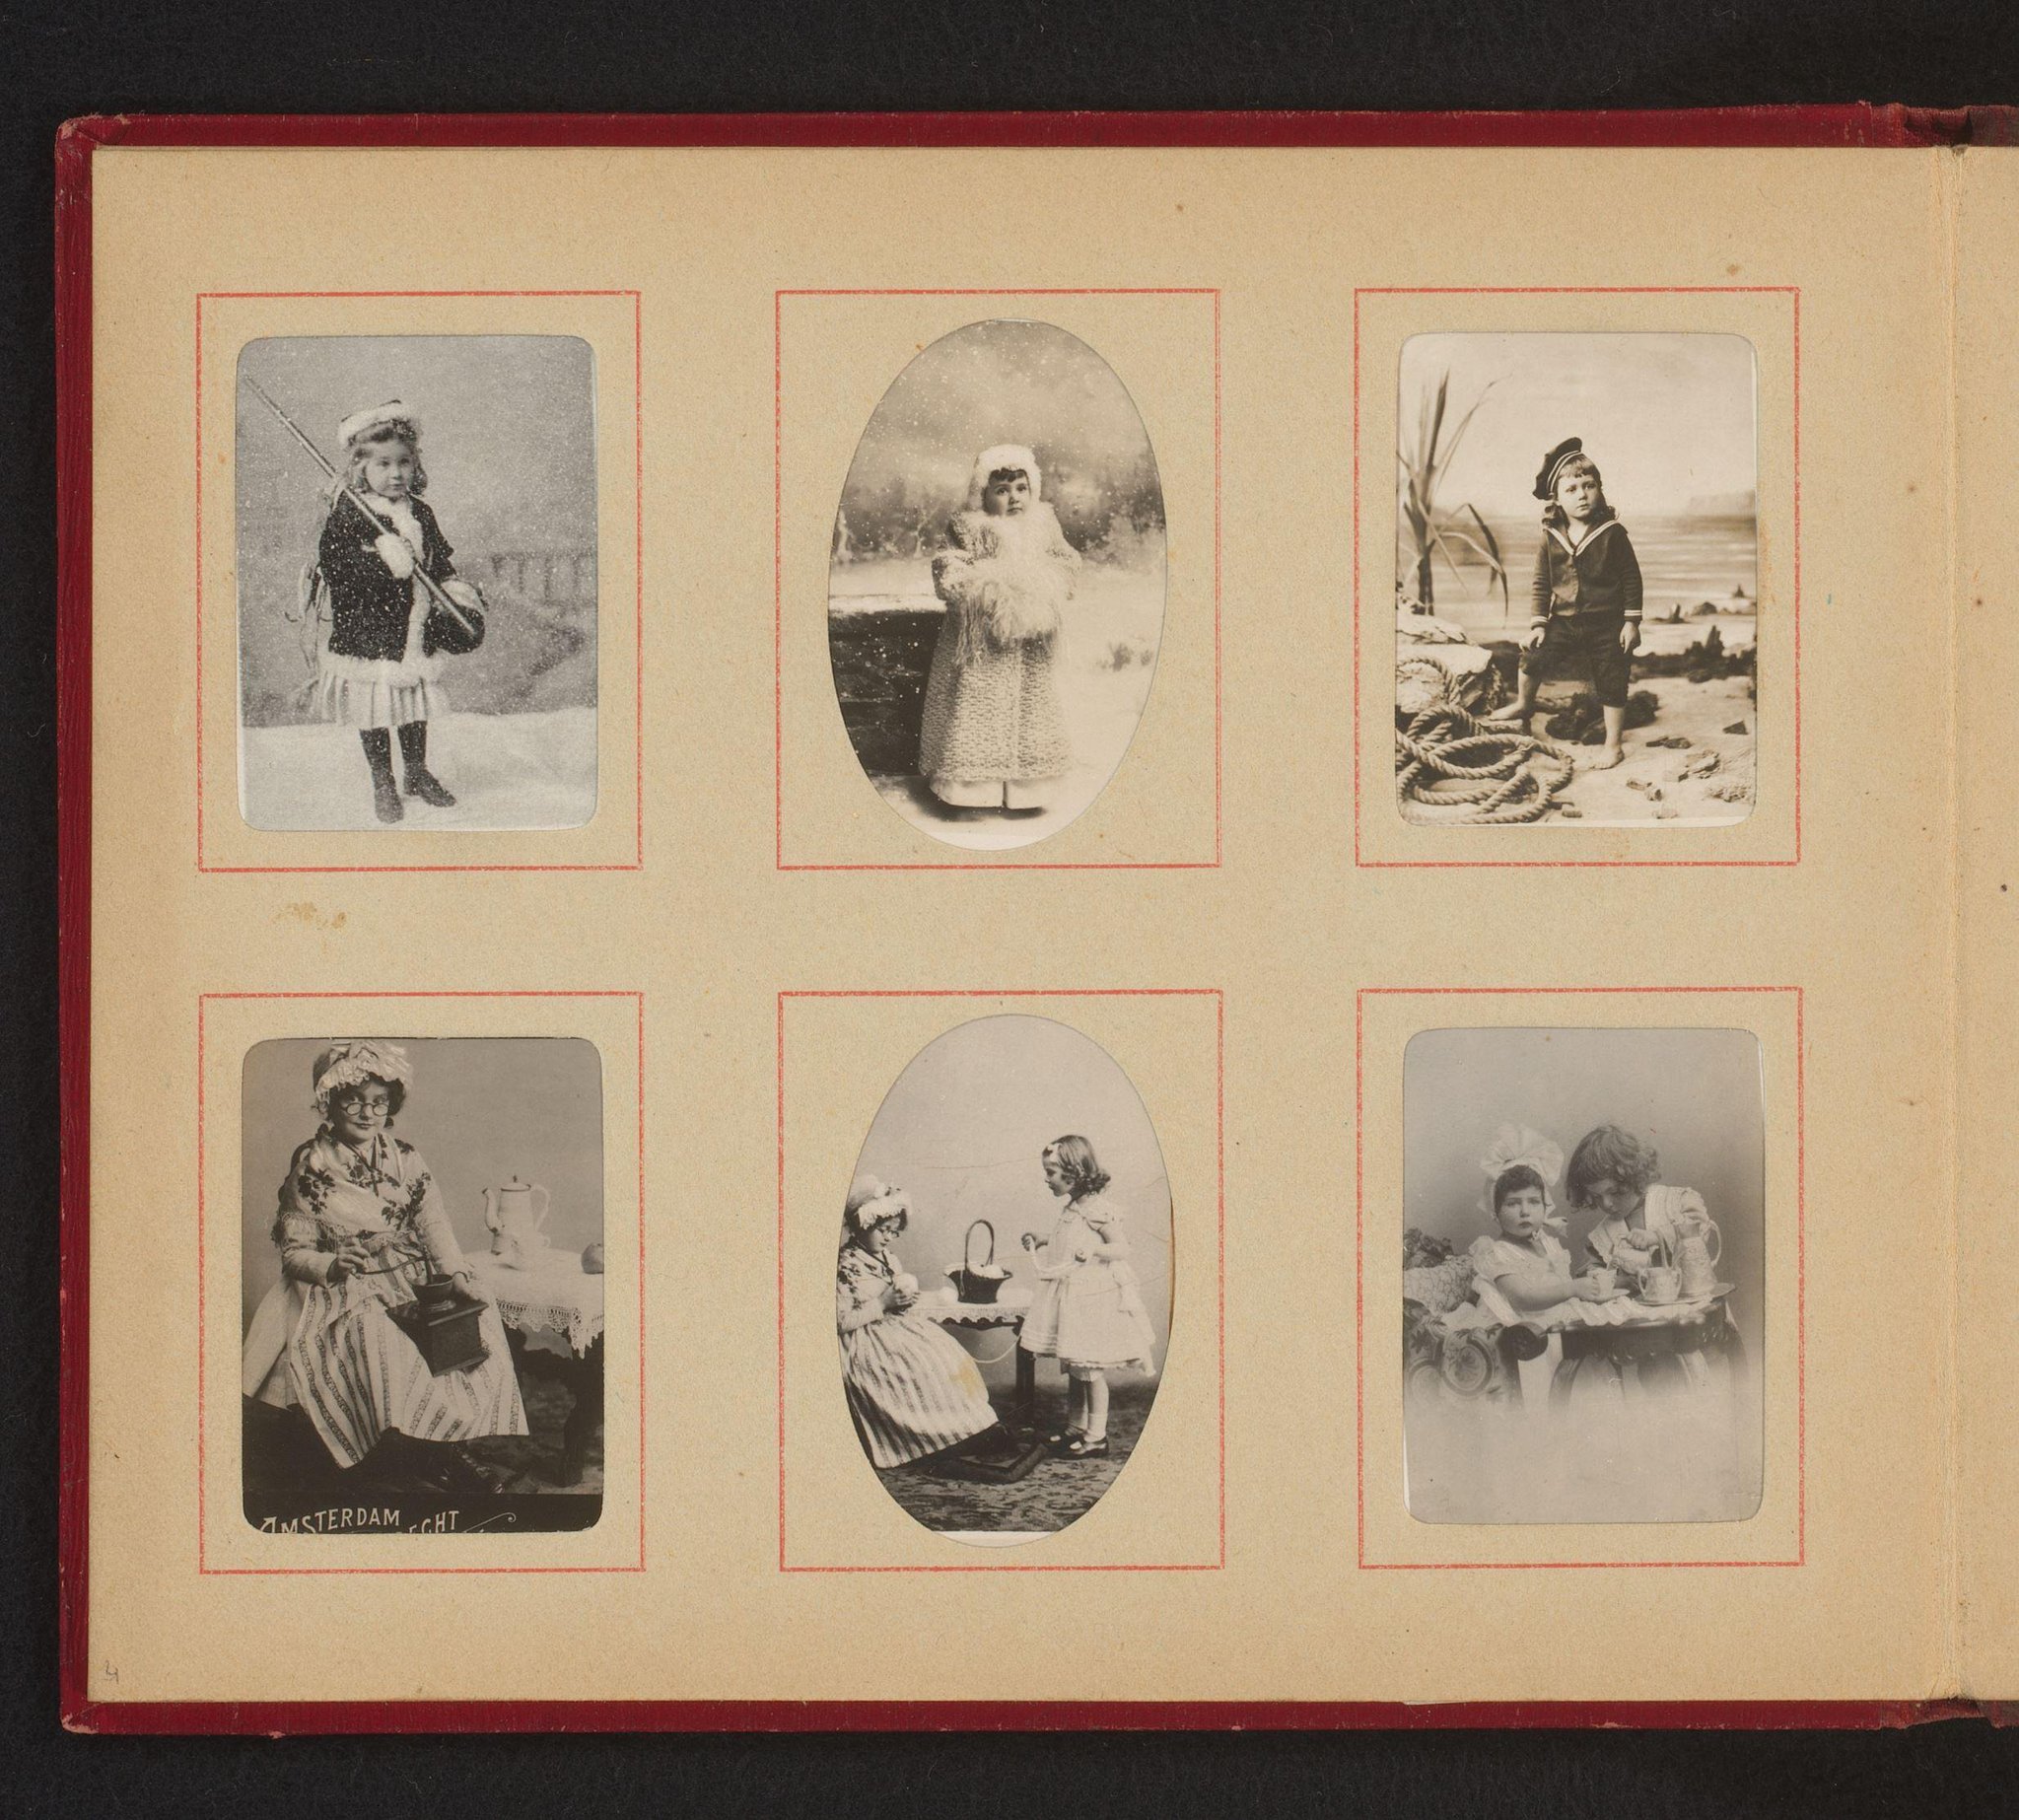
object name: photomechanical print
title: Kinderportretten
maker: Anonymous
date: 1880-1920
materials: photographic support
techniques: photograph, gelatin silver print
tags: child, historical persons, trade games, imitative games, imitating adults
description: Zes portretten van verklede kinderen. Deze pagina maakt deel uit van een album.